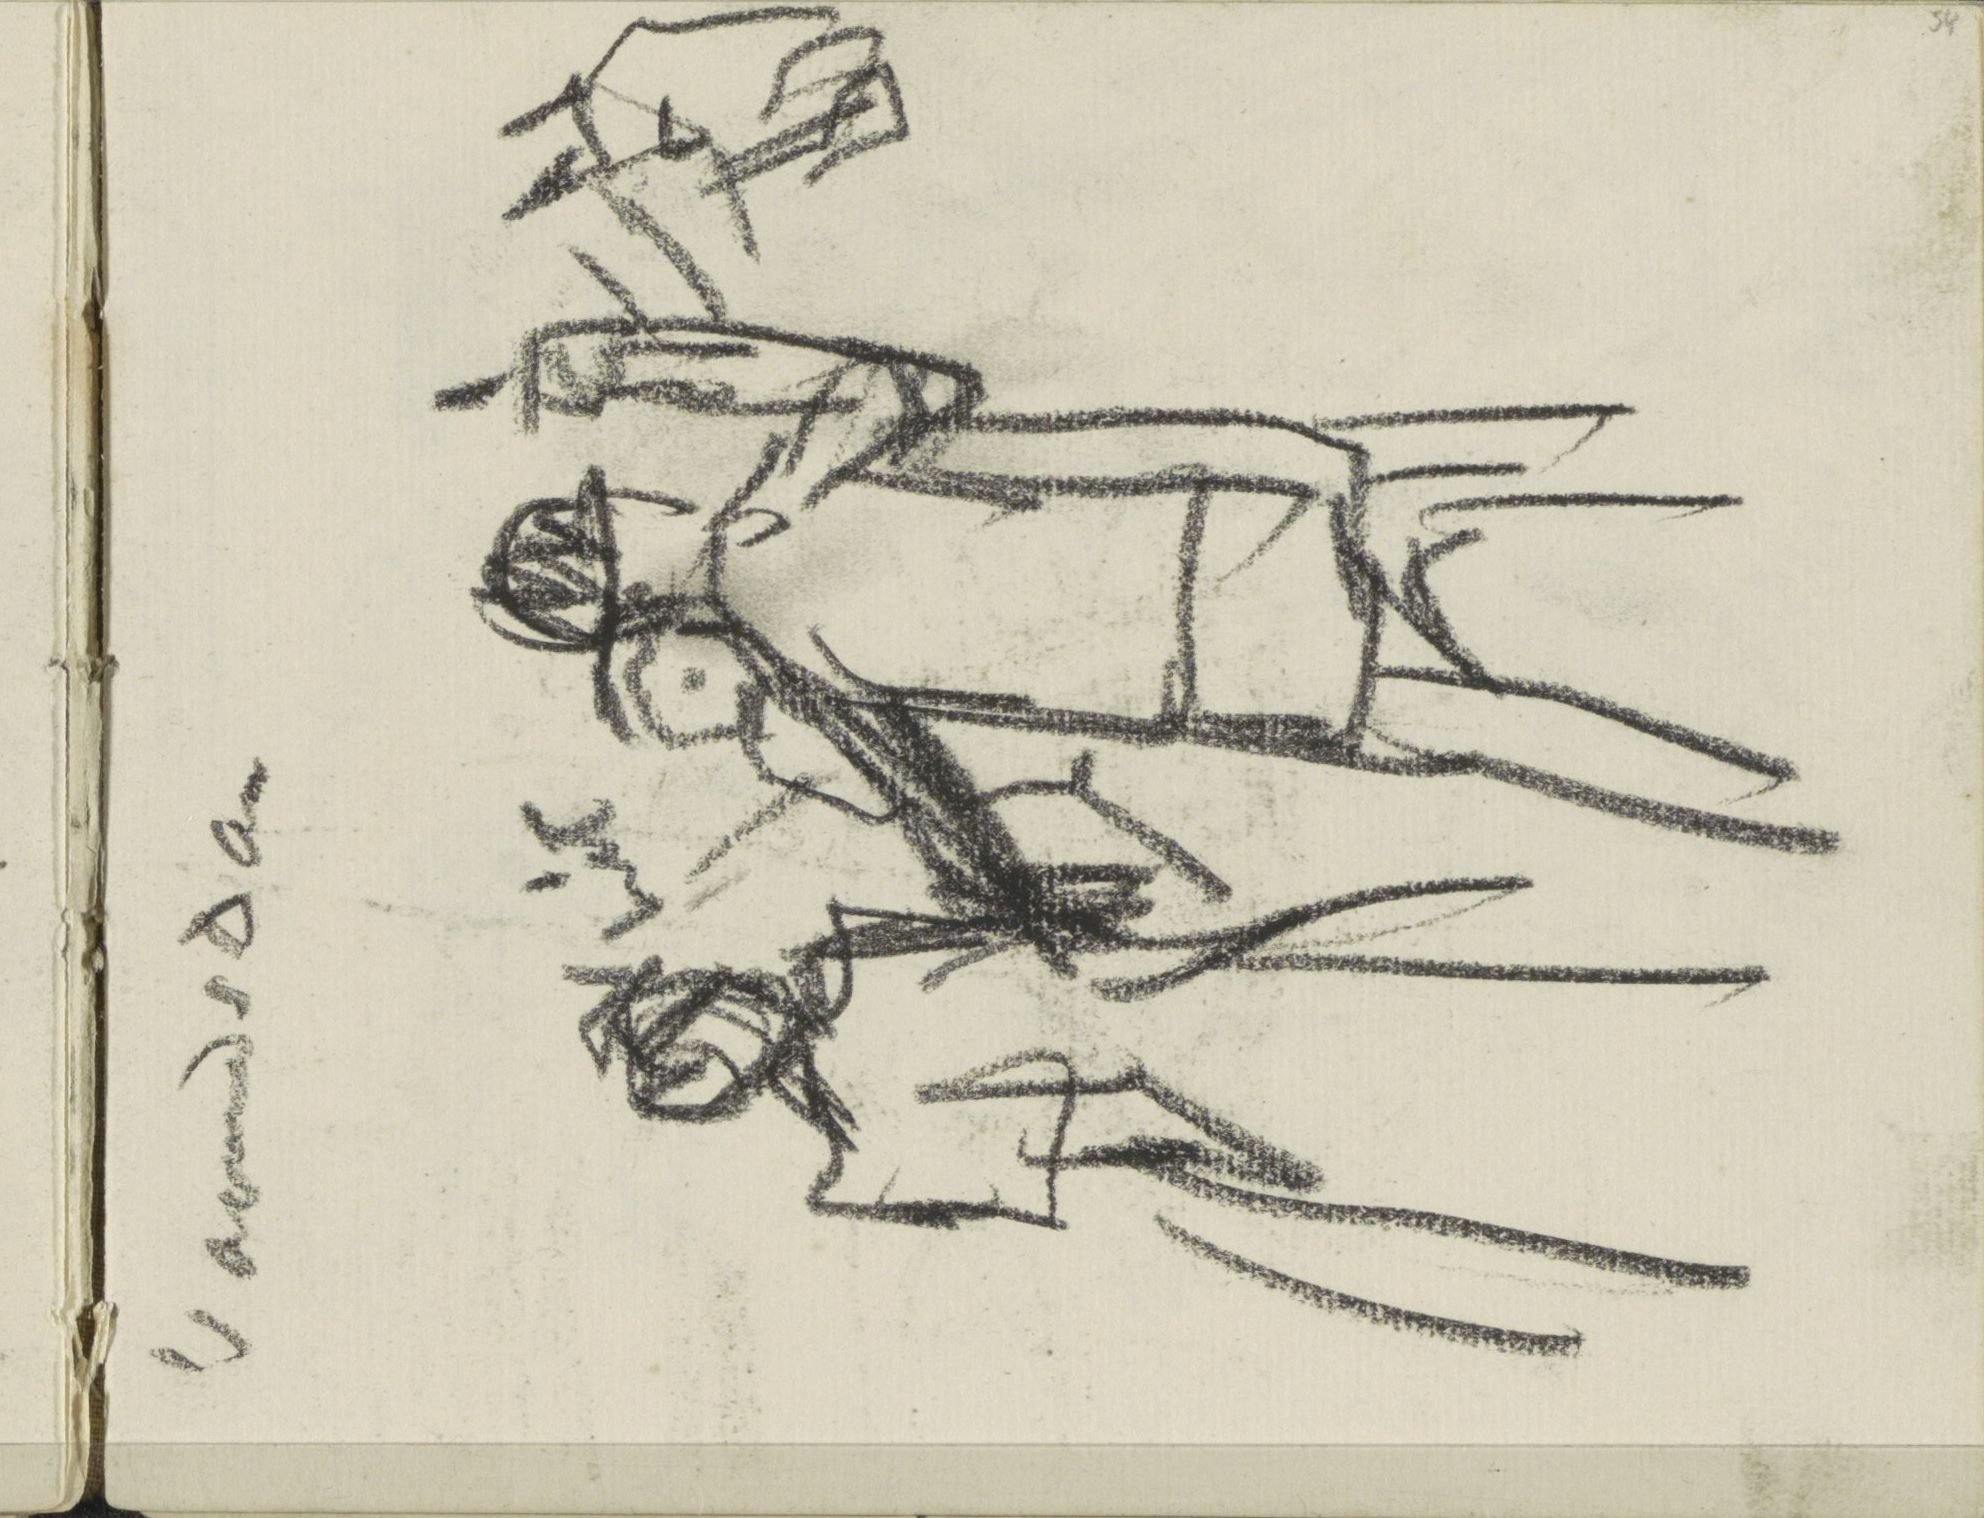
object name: sketchbook leaf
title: Man en vrouw bij een paard op de Dam te Amsterdam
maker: george hendrik breitner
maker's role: draughtsman, painter, print maker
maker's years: 1857-1923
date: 1893-1912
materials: chalk, paper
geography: amsterdam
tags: adult woman, adult man, horse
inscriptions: annotation: ‘'s avonds Dam’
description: Pagina 54 uit een schetsboek met 32 bladen.